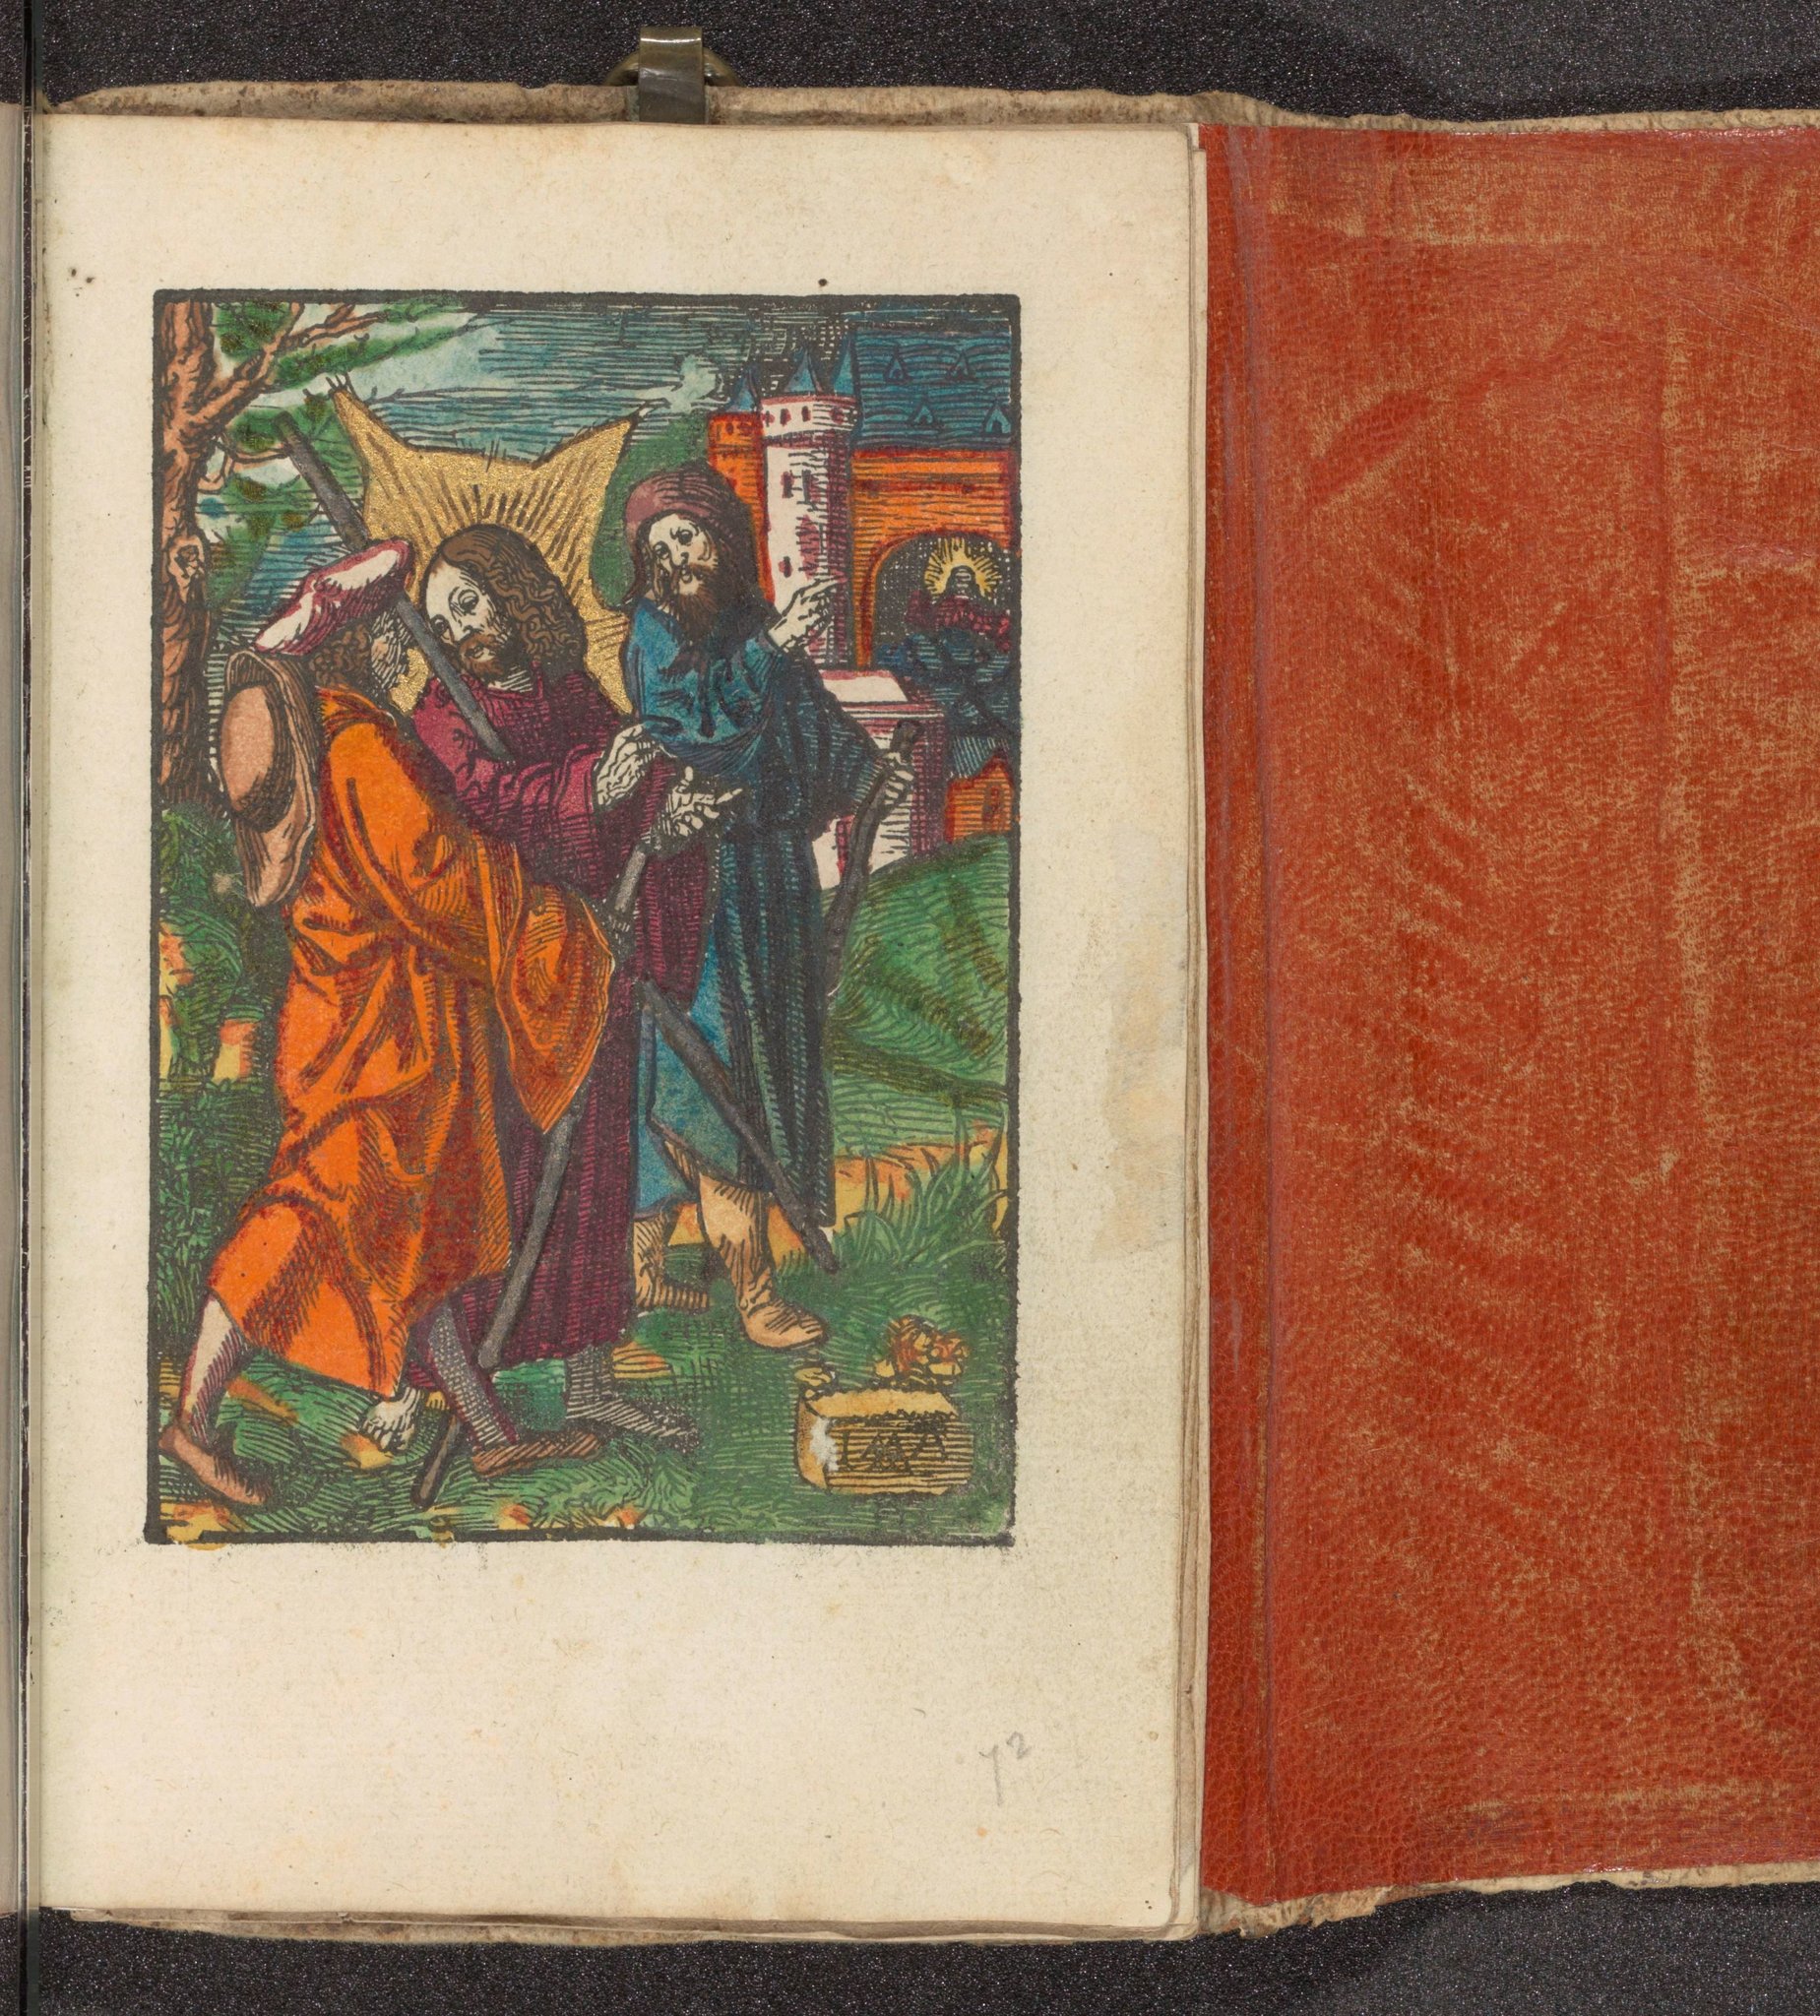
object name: print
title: Emmaüsgangers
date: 1520-1521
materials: paper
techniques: hand coloring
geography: amsterdam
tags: book in which illustrations are essential, cleopas and peter arrive at the gate of emmaus, or at the inn; christ is asked to stay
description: De opgestane Christus ontmoet twee leerlingen en loopt met hen mee naar het dorp Emmaüs. Zij herkennen Christus niet. Een van de mannen wijst op het dorp Emmaüs. Prent maakt deel uit van een boek.